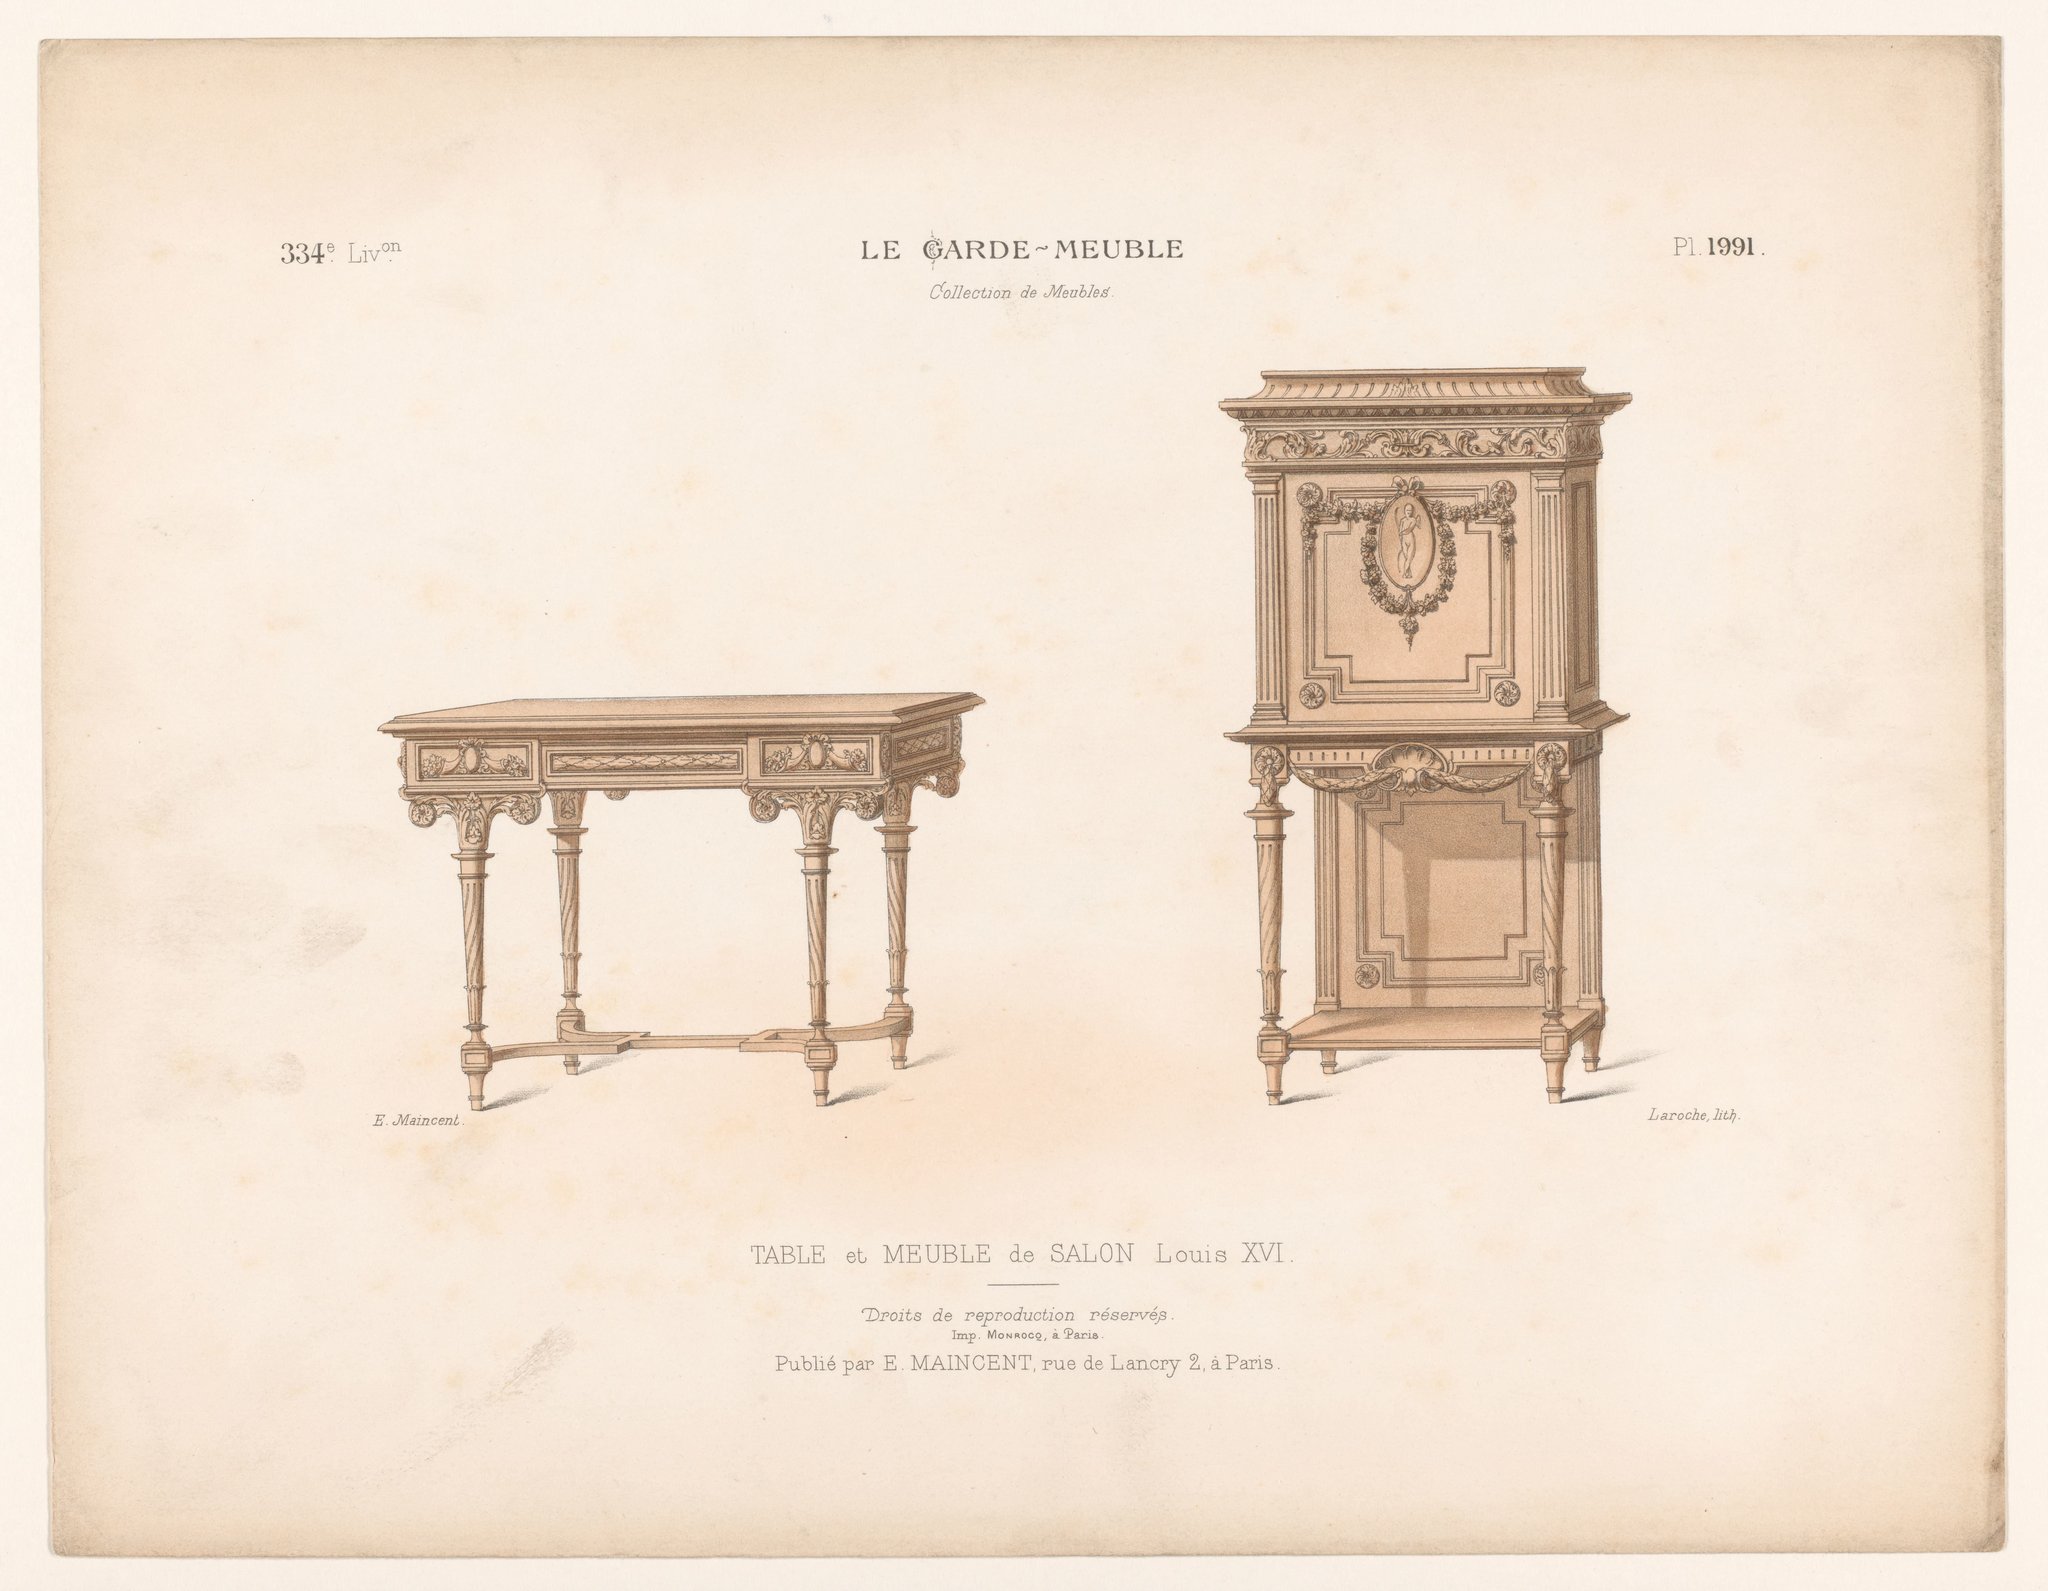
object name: print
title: Le garde-meuble / Collection de Meubles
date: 1885-1895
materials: paper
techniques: hand coloring, lithograph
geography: paris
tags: table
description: Ieder Livraison in de serie Le Garde-Meuble bevat negen platen: drie 'sièges' (zitmeubels), drie 'meubles' (diverse meubels zoals tafels en kasten) en drie 'tentures' (gordijnen en draperieën).